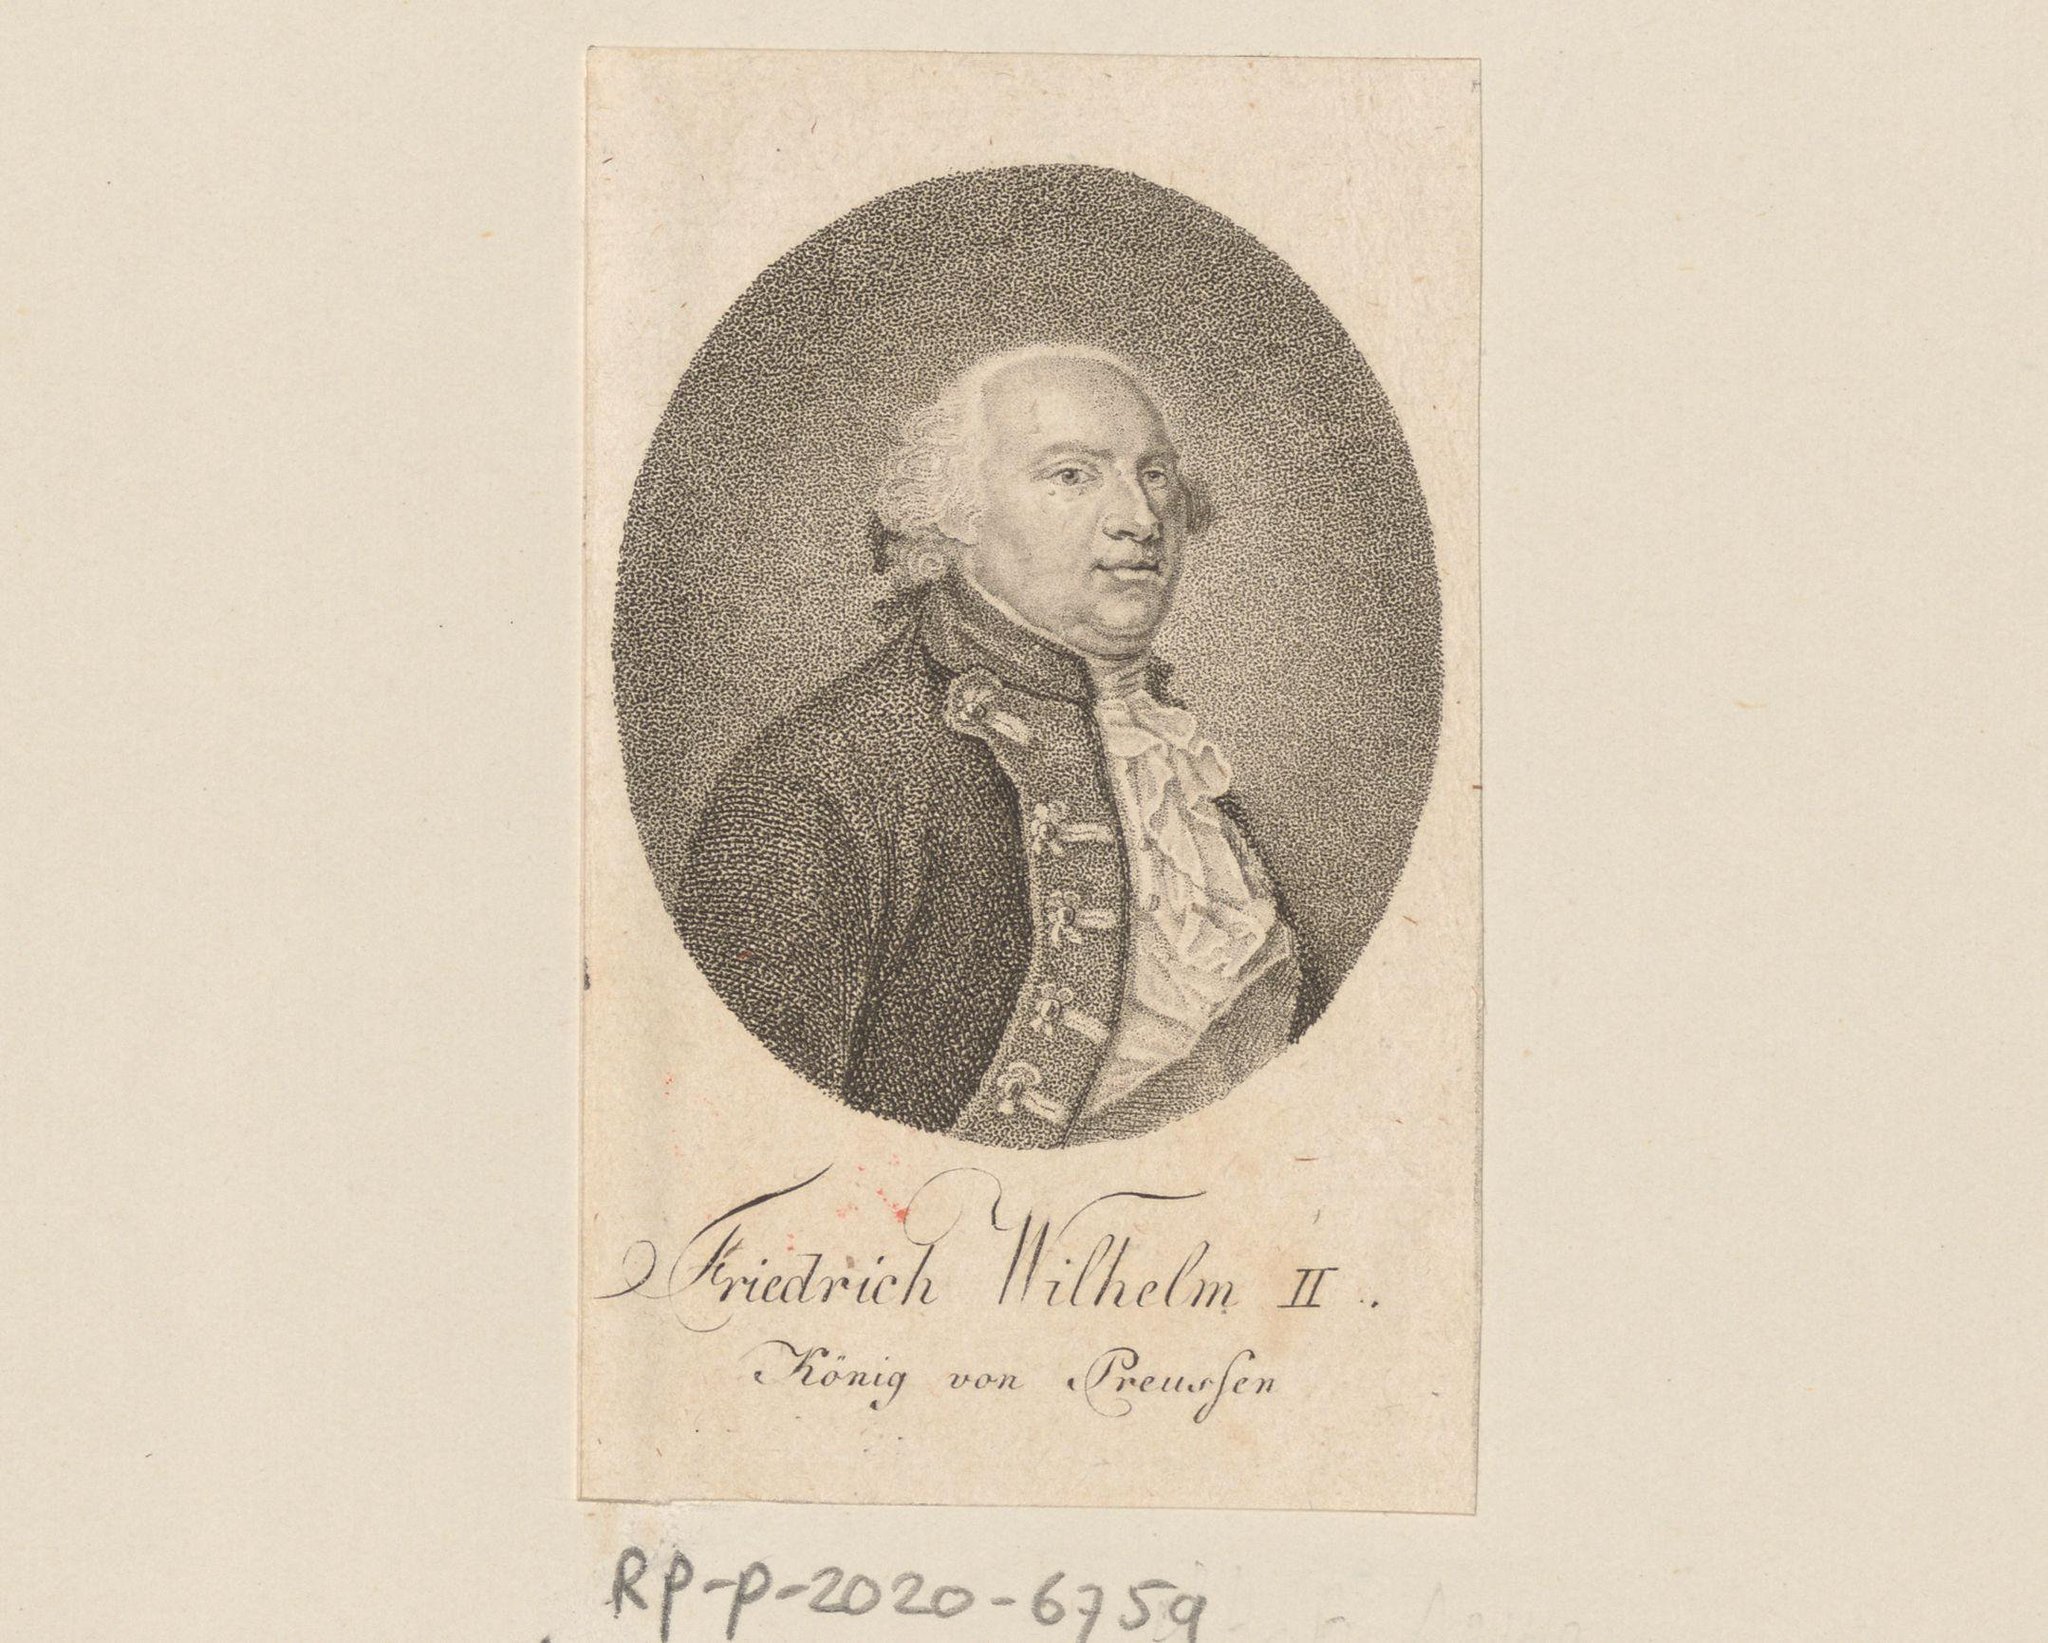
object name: print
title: Portret van Frederik Willem II van Pruisen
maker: Anonymous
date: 1786-1800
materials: paper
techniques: engraving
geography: germany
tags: berlin, frederik willem ii (koning van pruisen), historical persons, king